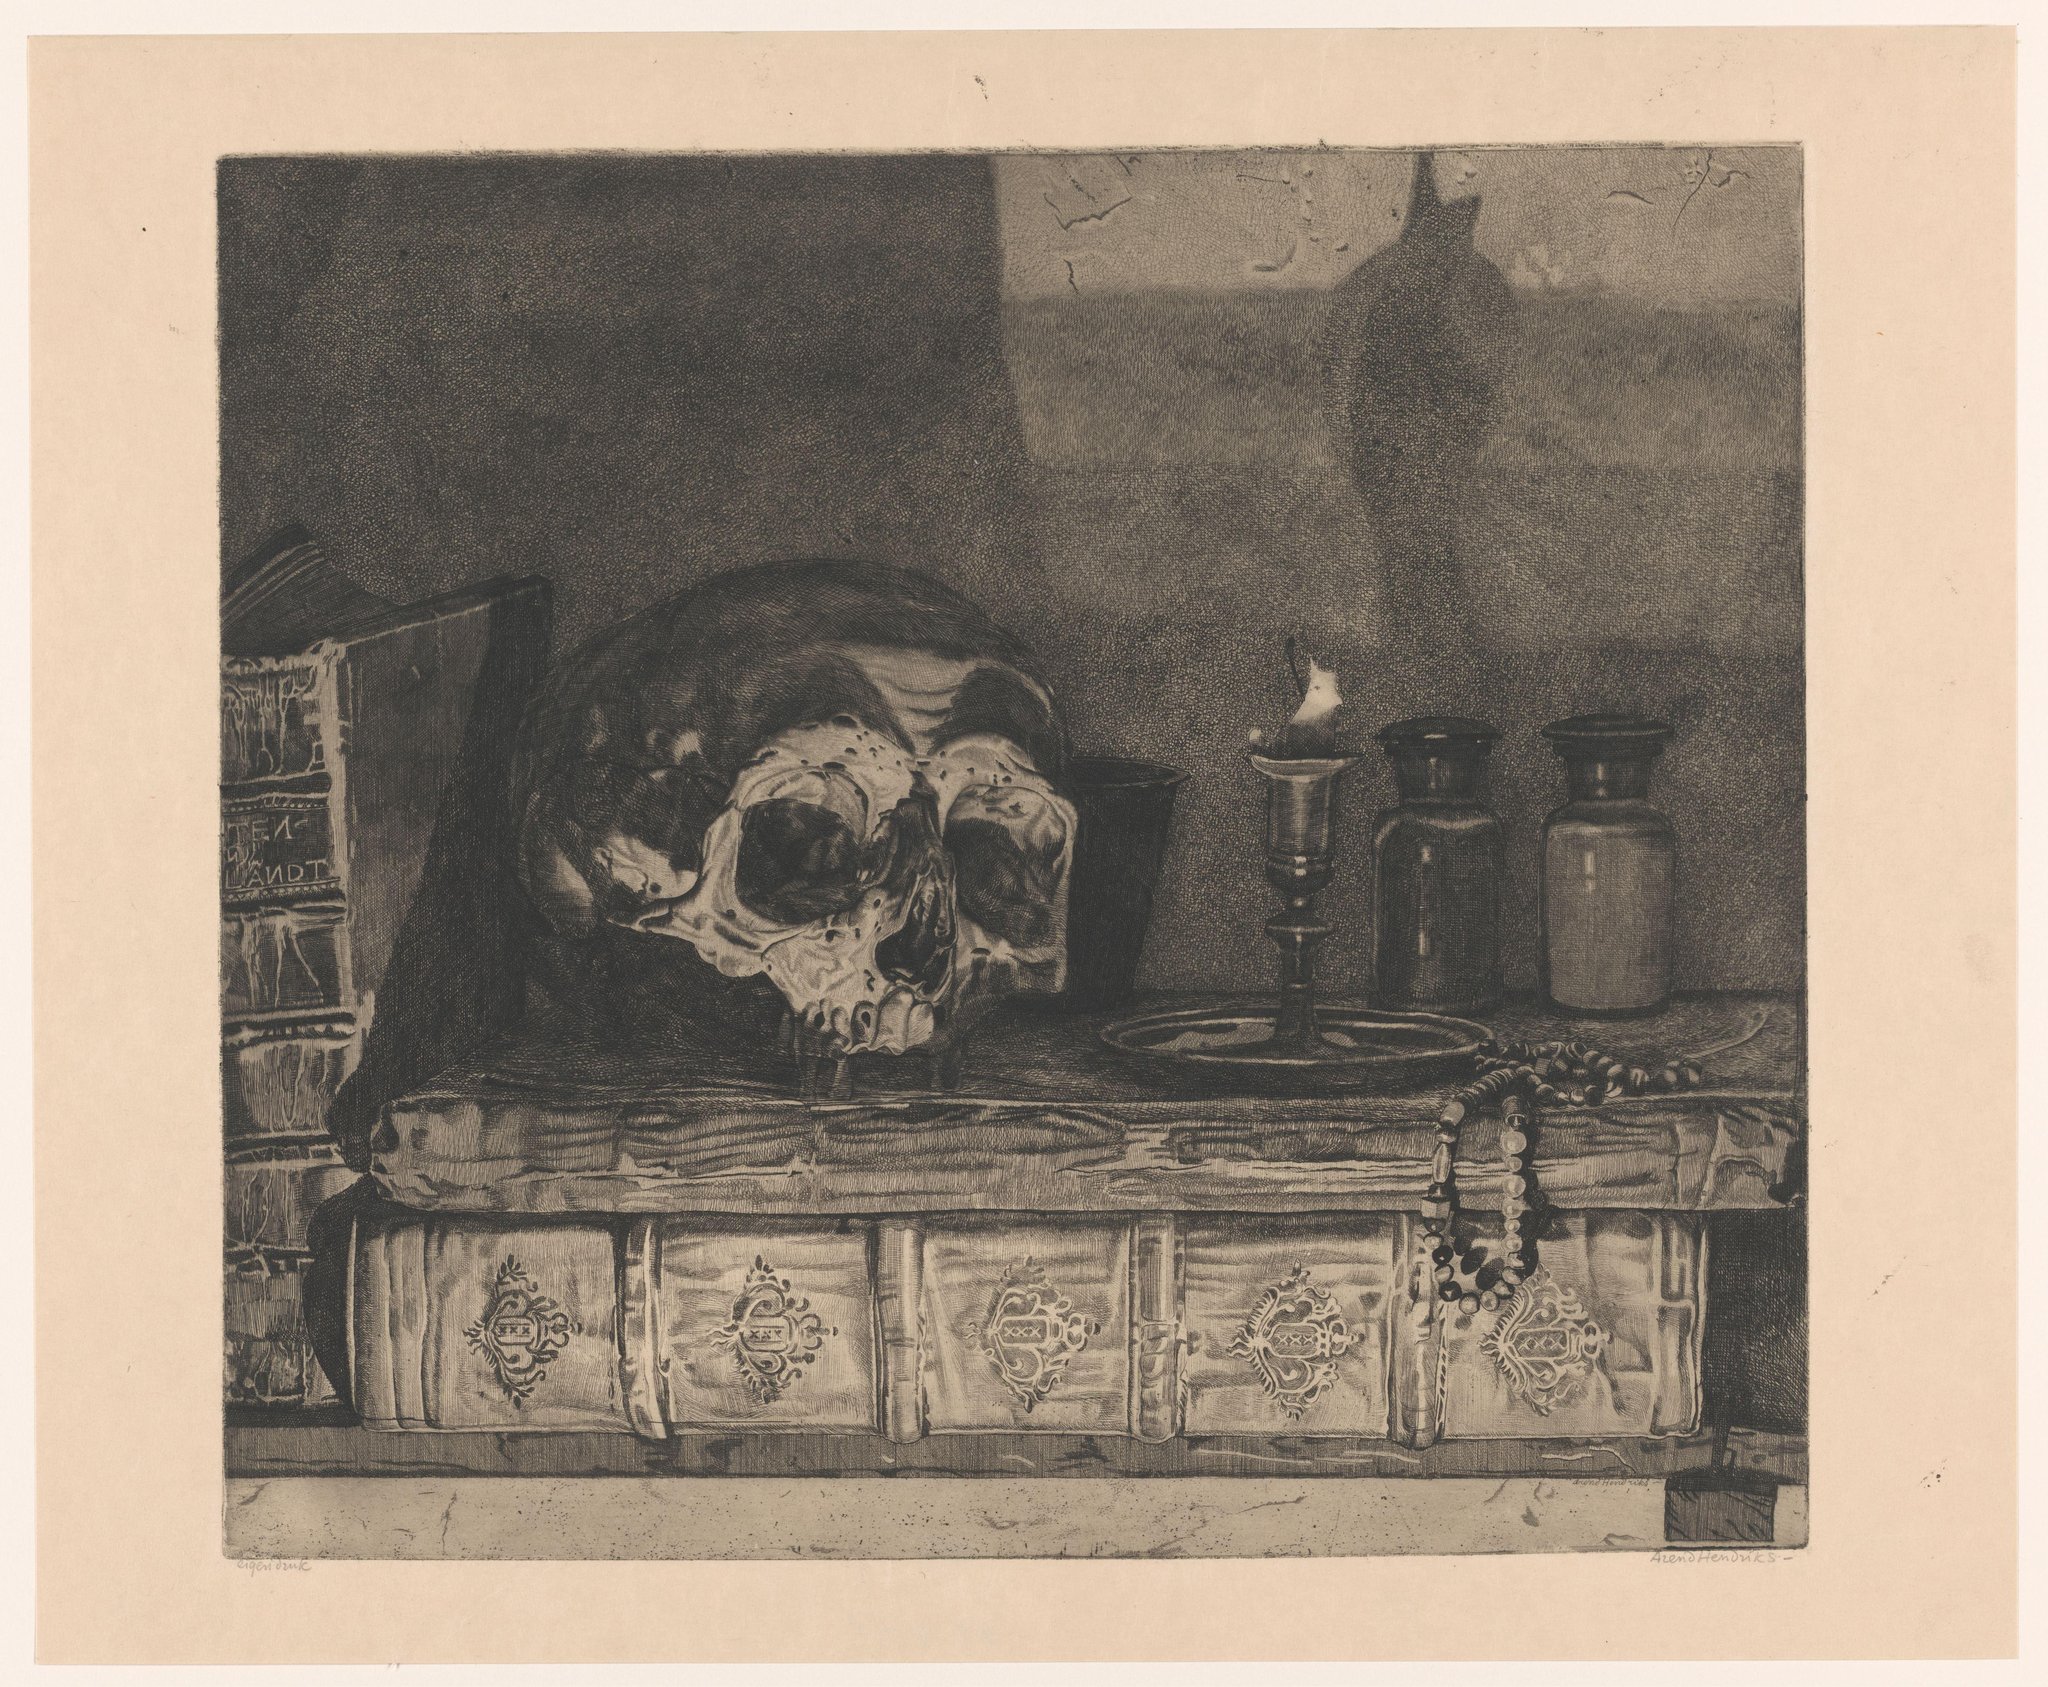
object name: print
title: Stilleven met schedel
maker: arend hendriks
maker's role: print maker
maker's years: 1901-1951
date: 1911-1943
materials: paper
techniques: etching, intaglio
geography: netherlands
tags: 'vanitas' still life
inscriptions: collector's mark: Lugt 2228